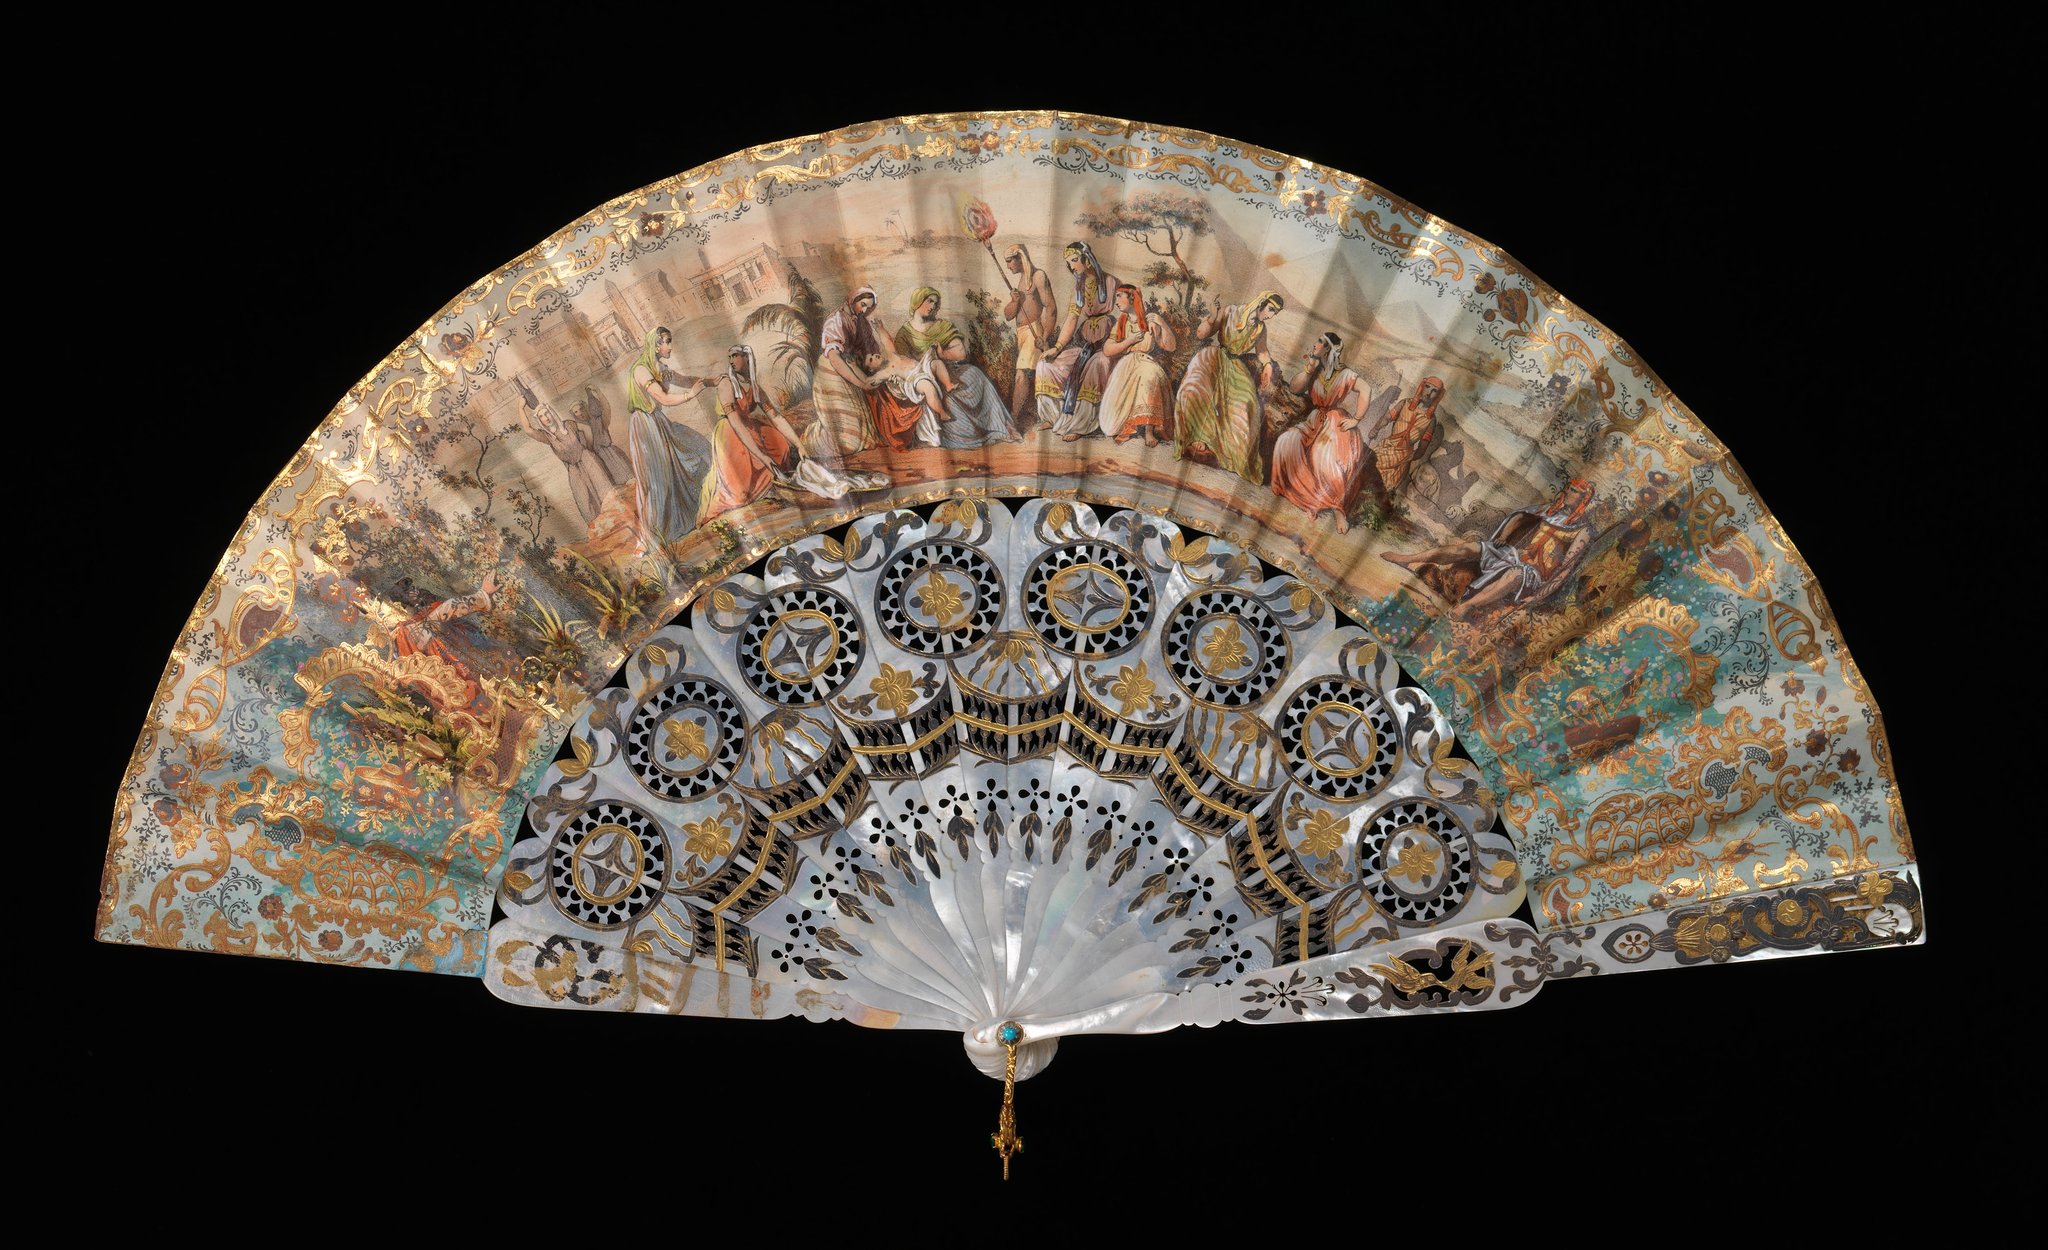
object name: fan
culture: european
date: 1855-1865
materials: metal, mother of pearl, paper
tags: pyramids,men,women,moses